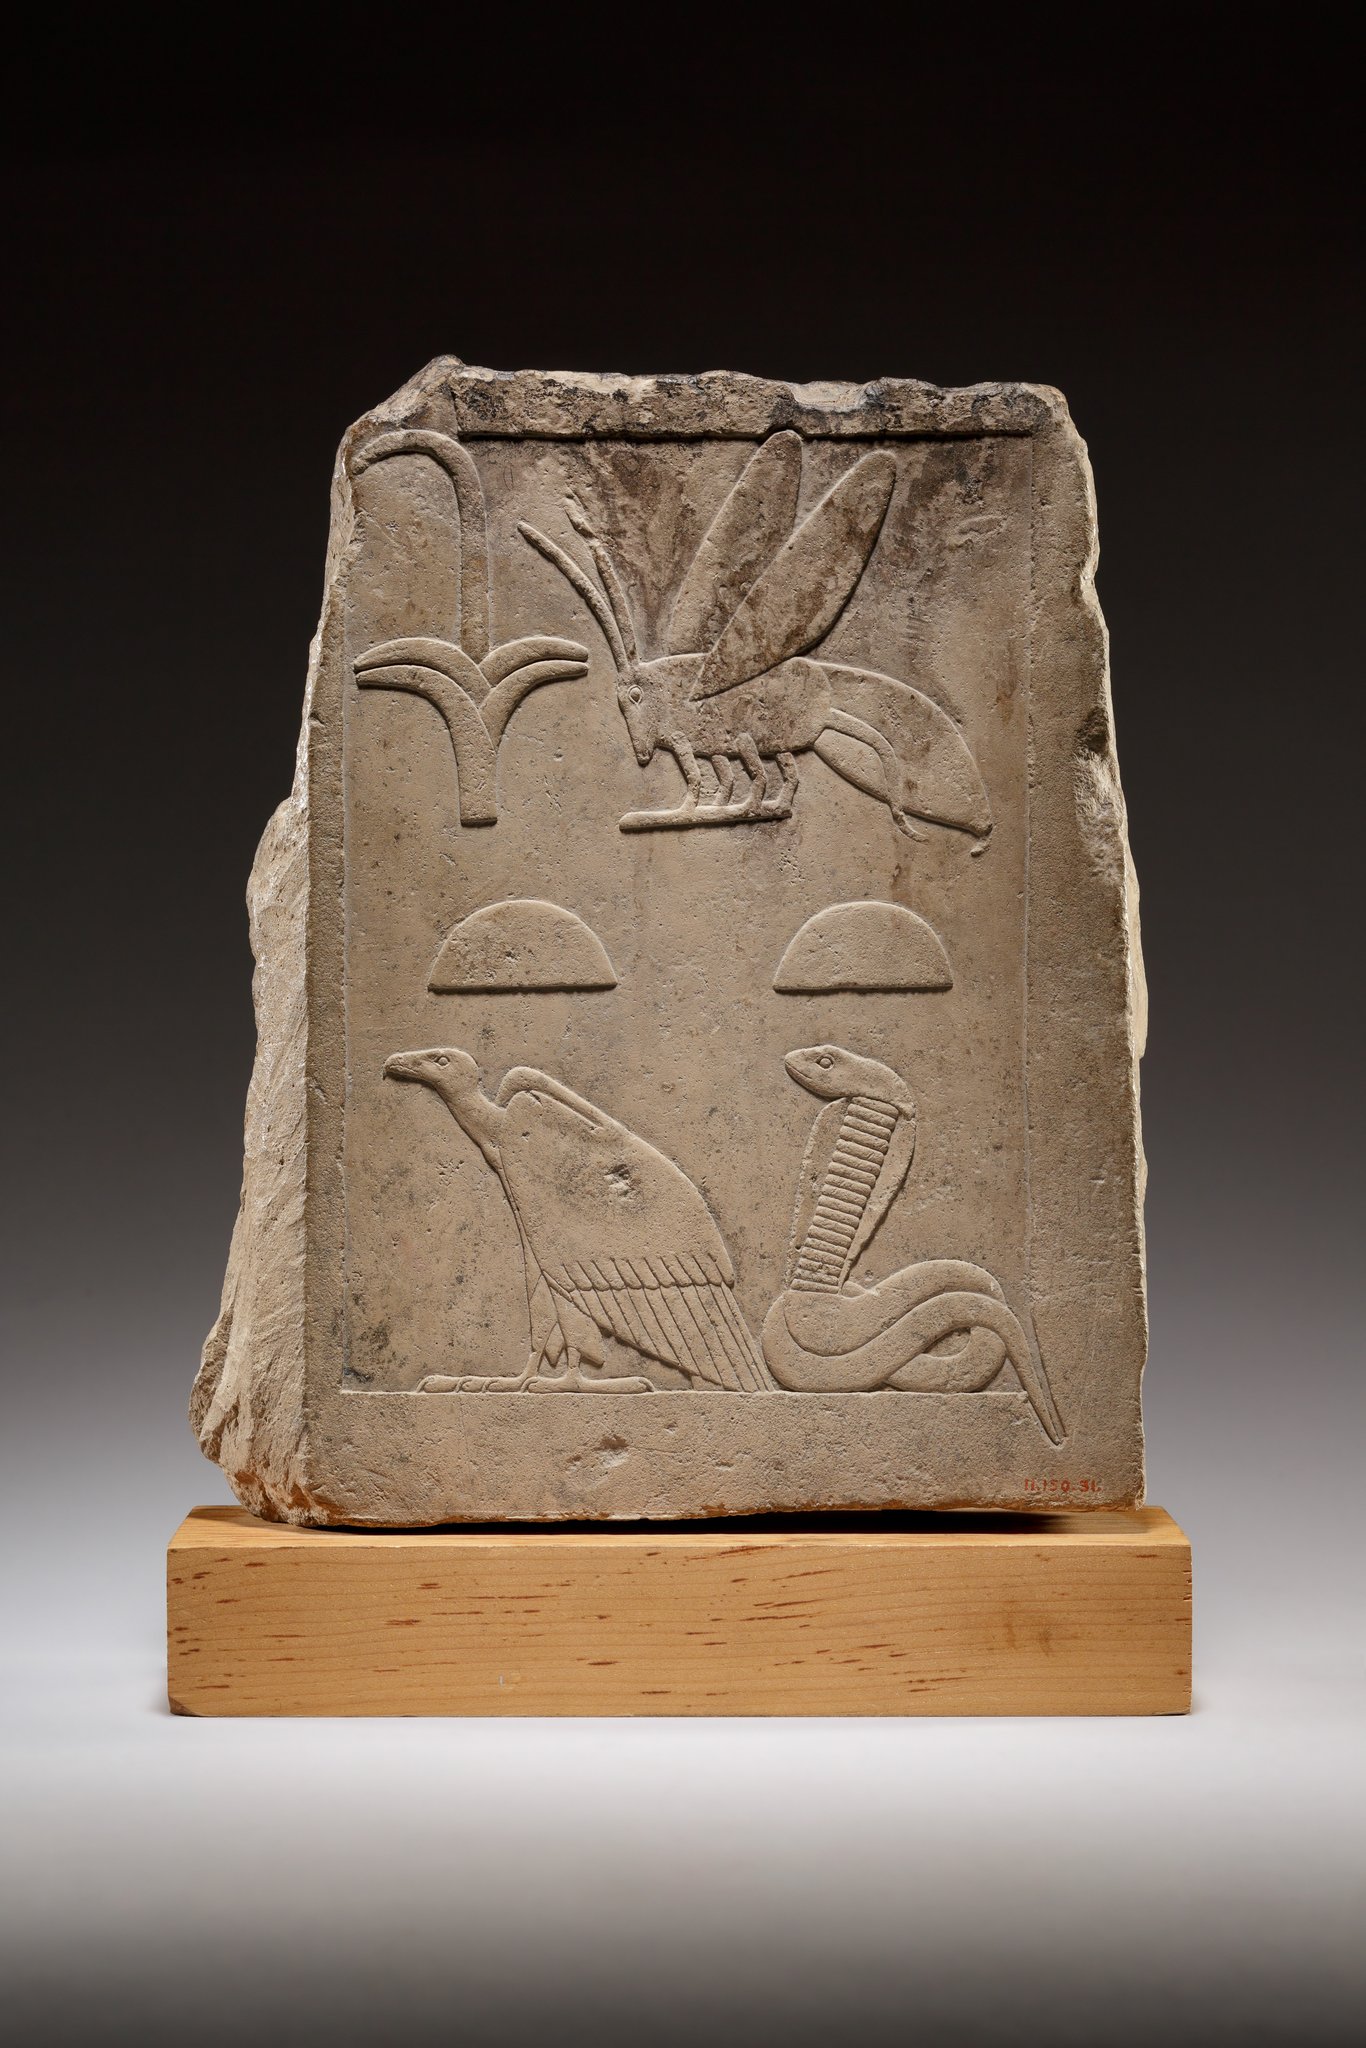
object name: sculptor's model votive, relief plaque with royal titulary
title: Plaque Inscribed with Royal Titles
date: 767-735 BCE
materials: limestone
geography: the delta